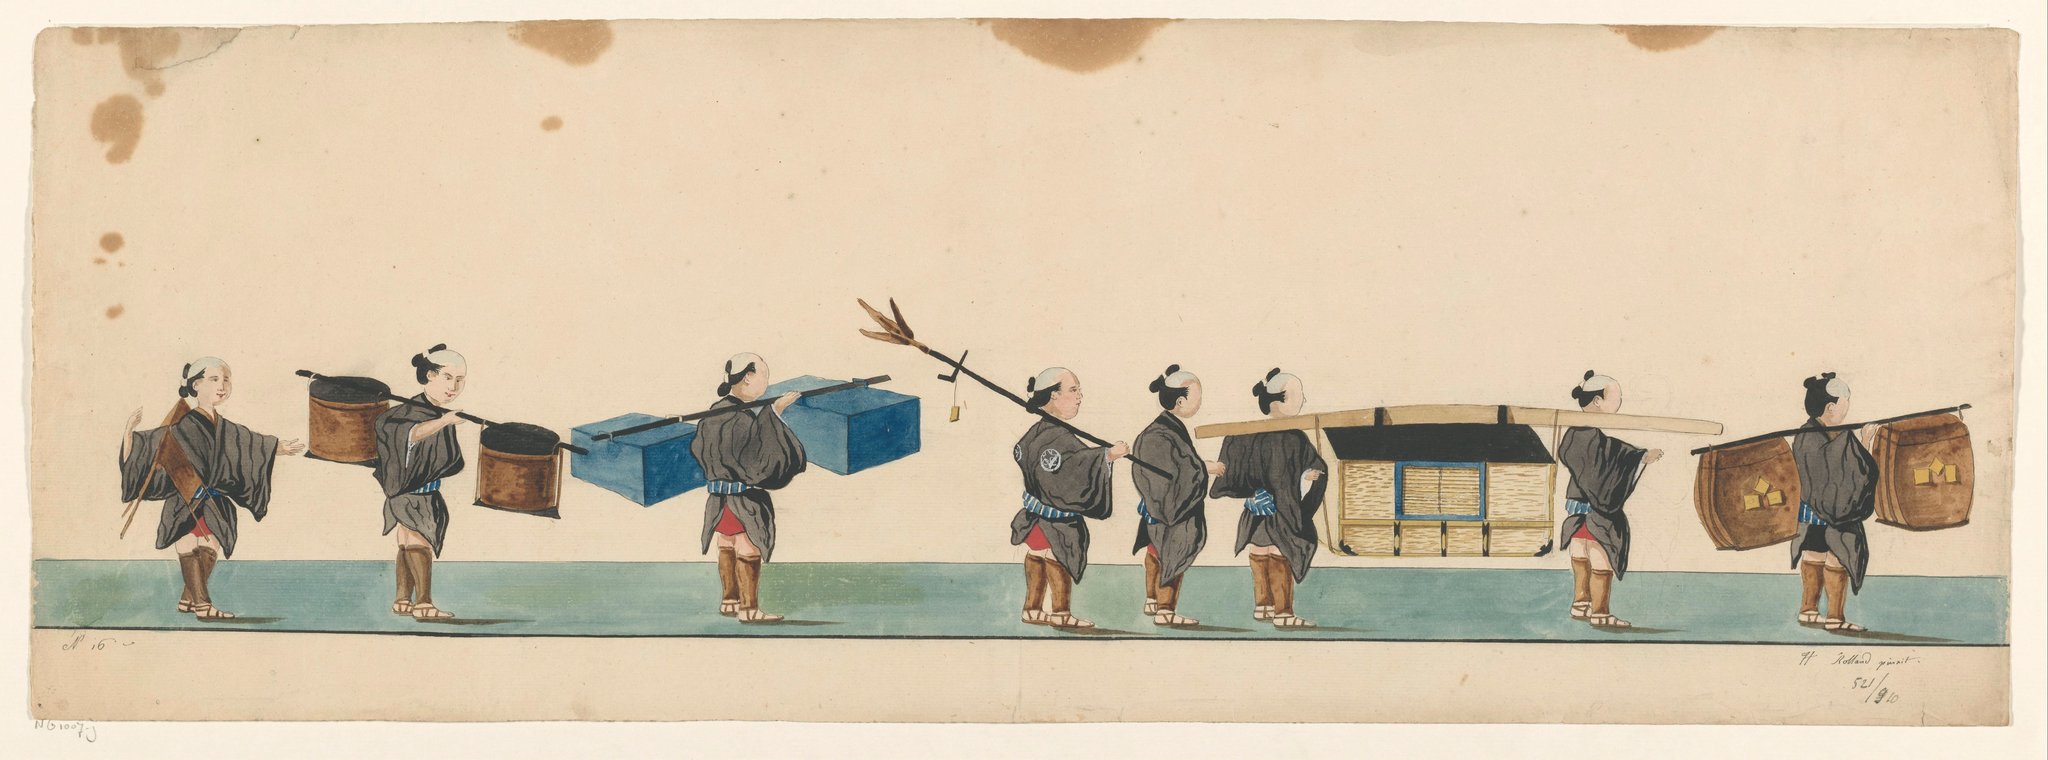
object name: drawing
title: Stoet van acht Japanse dragers met pakketten aan draagstokken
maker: henry rolland de verberie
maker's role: painter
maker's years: 1750-1800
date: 1775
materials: ink, paper, watercolor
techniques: brush, pen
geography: japan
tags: carrying something with carrying-pole, (carrying a person in a) sedan-chair, japan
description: Stoet van acht Japanse dragers met pakketten aan draagstokken, naar rechts. Onderdeel van een reeks van tien pentekeningen met een stoet van paarden geleid door Japanse mannen, die naar rechts en op twee bladen naar links zich bewegen, en pakketten dragen met deels het embleem van de VOC Zeeland. Genummerd linksonder: No. 16., rechtsonder: 521/10.